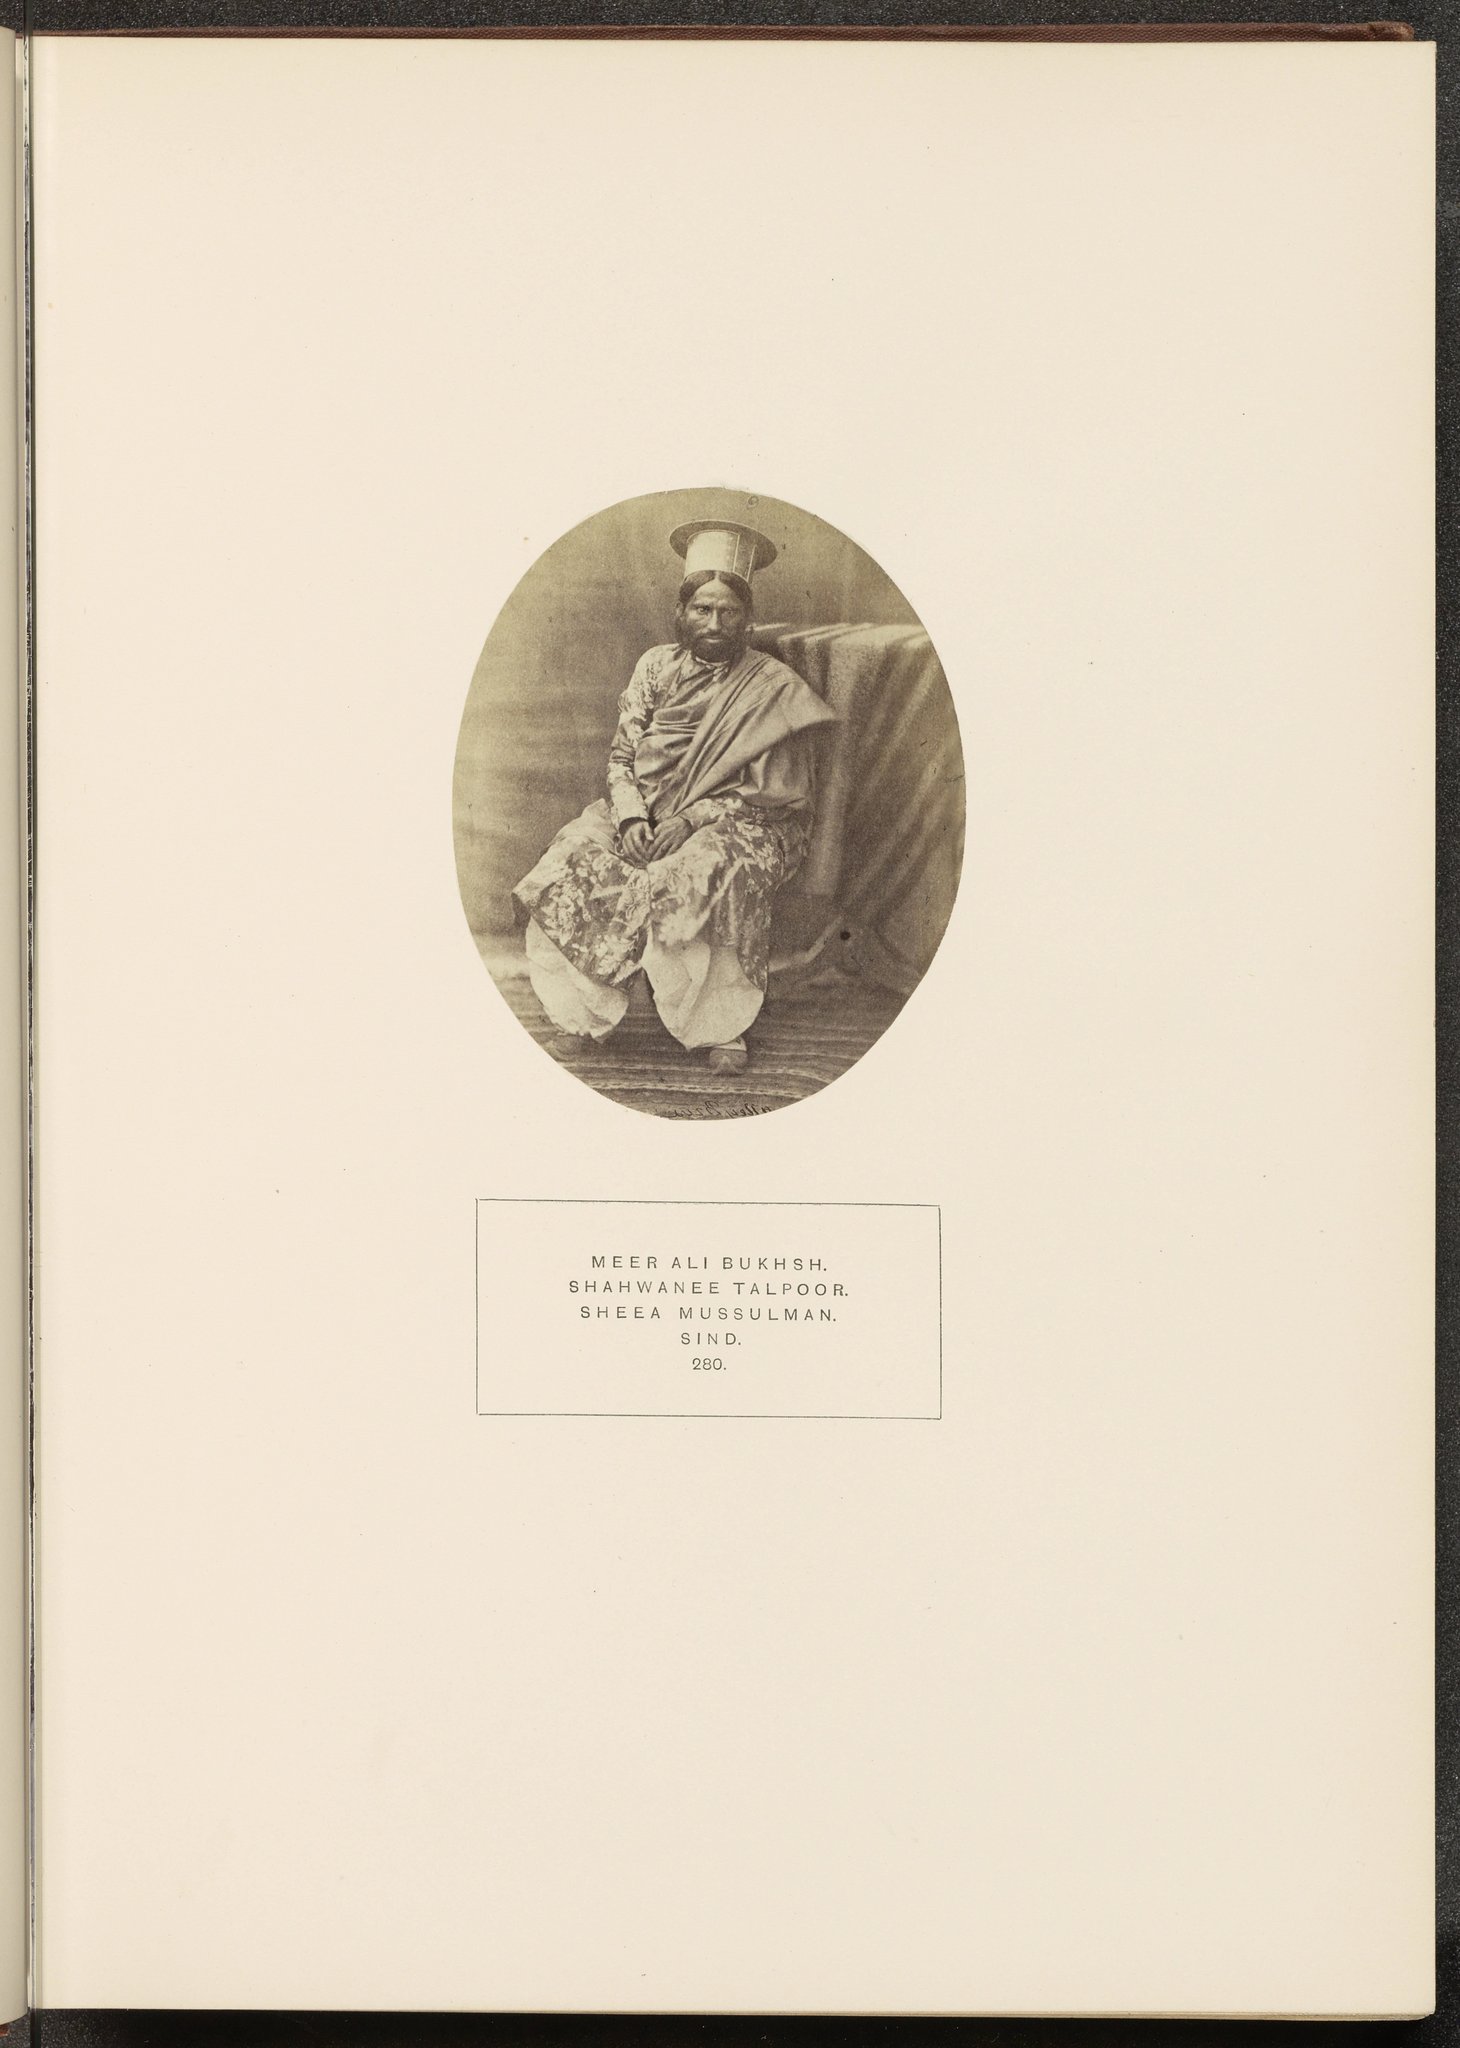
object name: page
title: Portrait of Mir Ali Bukhsh, Sindh, Pakistan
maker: henry charles baskerville tanner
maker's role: fotograaf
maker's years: 1835-1898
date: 1862-1872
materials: photographic support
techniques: albumen print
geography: sindh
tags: ruler, sovereign, human races; peoples; nationalities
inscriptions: inscription: ‘[...] Bsu [...]’, inscription: ‘MEER ALI BUKHSH./ SHAHWANEE TALPOOR./ SHEEA MUSSULMAN./ SIND/’, number: ‘280.’